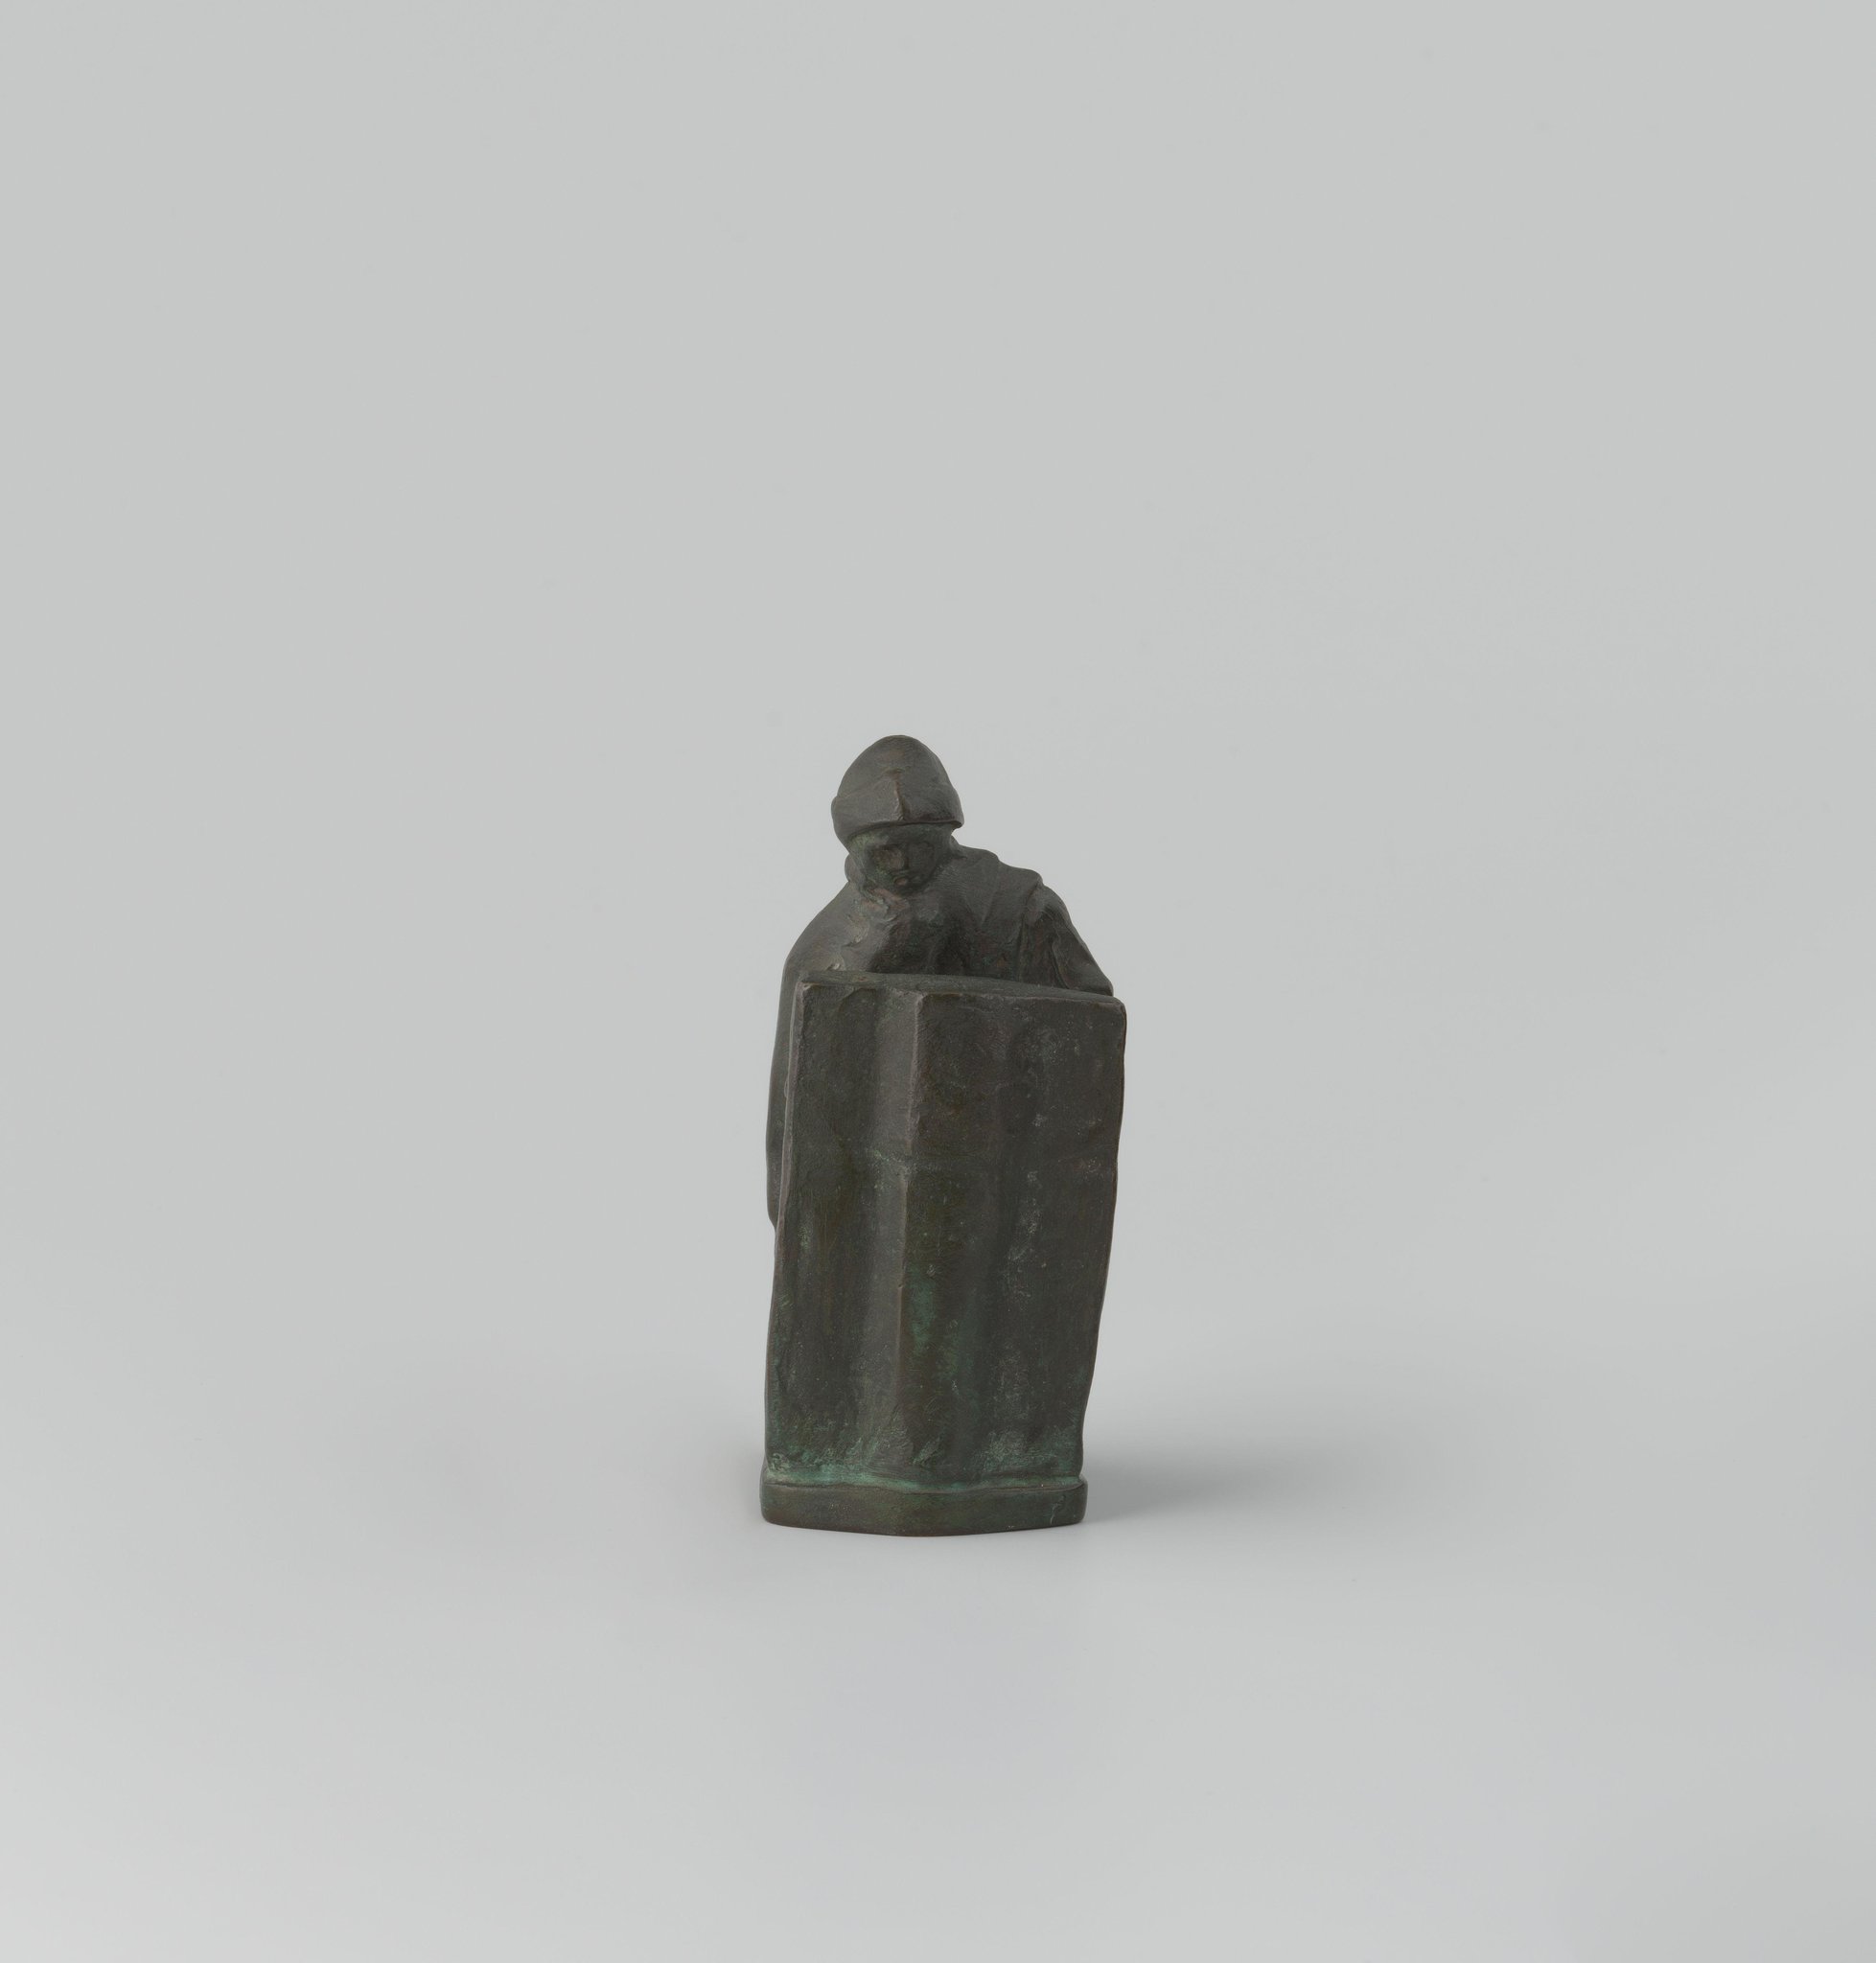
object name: chess piece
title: Wachter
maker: saar de swart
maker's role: sculptor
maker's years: 1861-1951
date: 1923-1925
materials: bronze, oxide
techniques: casting, lost wax process, patinaed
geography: capri